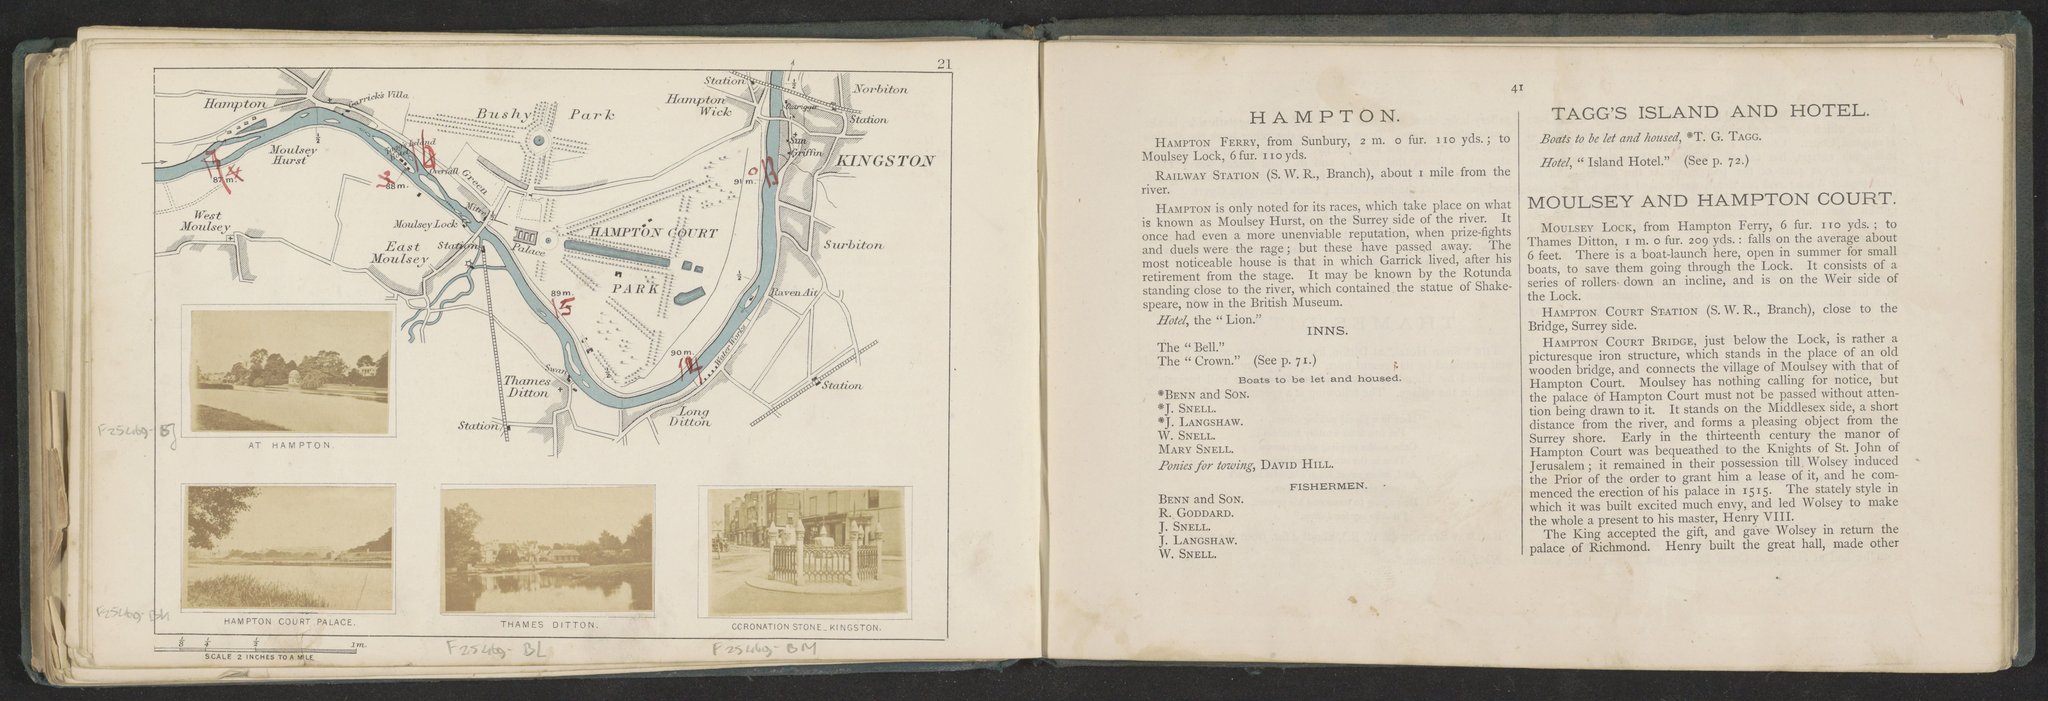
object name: page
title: Hampton Court Palace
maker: henry w. taunt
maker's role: fotograaf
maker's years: 1842-1922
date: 1871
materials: photographic support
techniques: albumen print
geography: surrey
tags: river, palace, thames